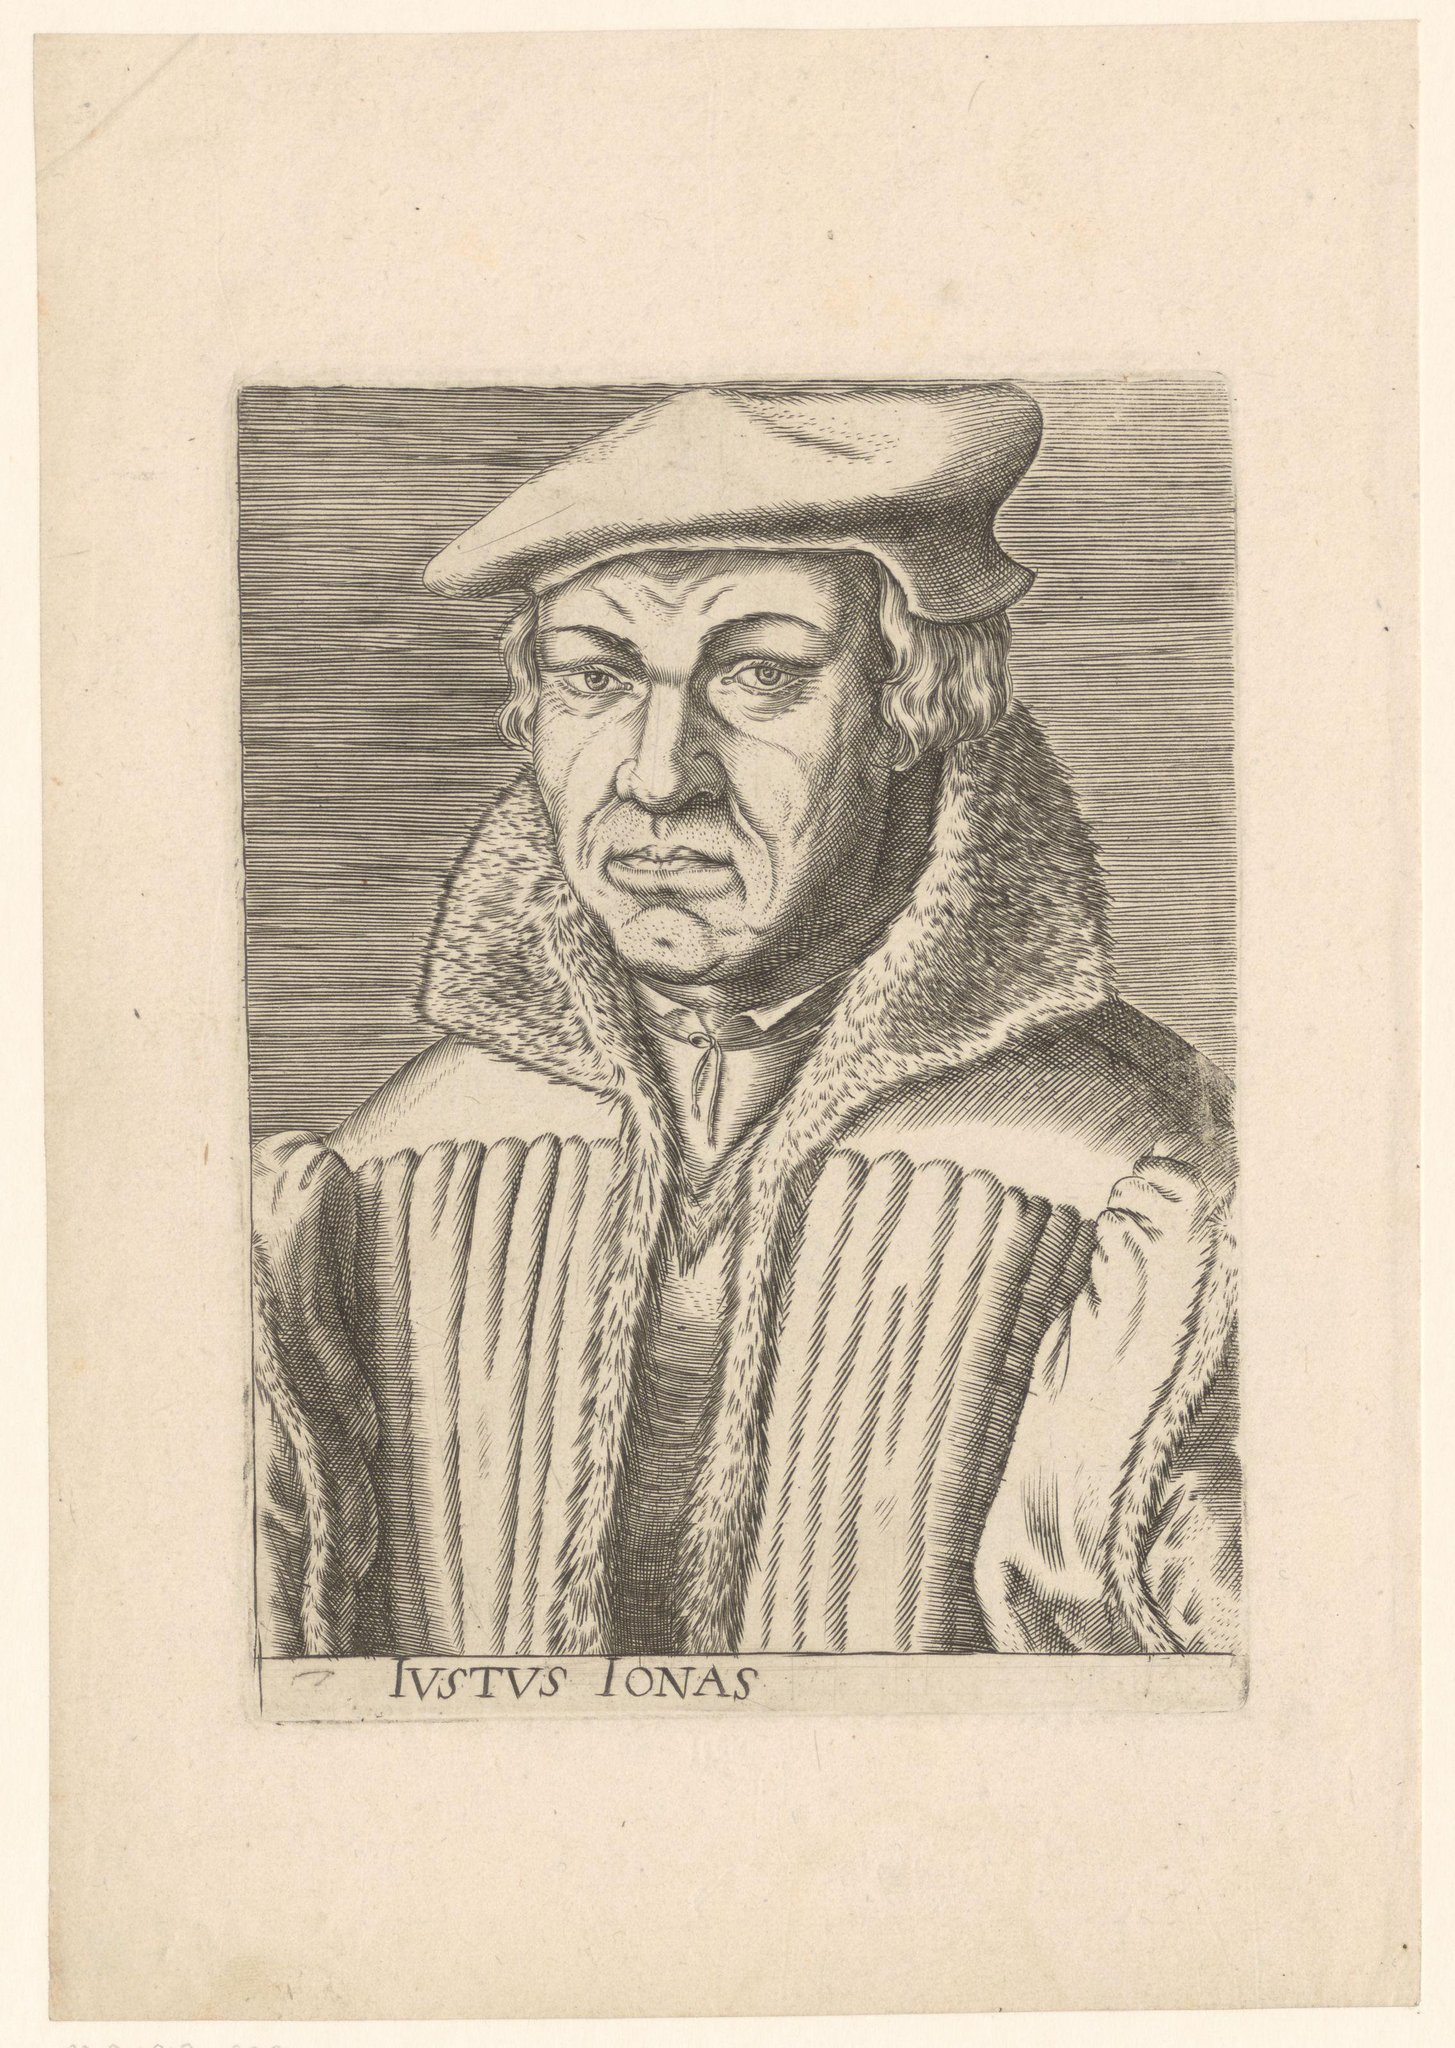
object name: print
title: Portret van Justus Jonas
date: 1563-1642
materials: paper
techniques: etching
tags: theologian, historical persons, portrait of composer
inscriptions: collector's mark: Lugt 2228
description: Deze prent (een impressie) hoort bij een serie portretten van sturende personen tijdens de reformatie.